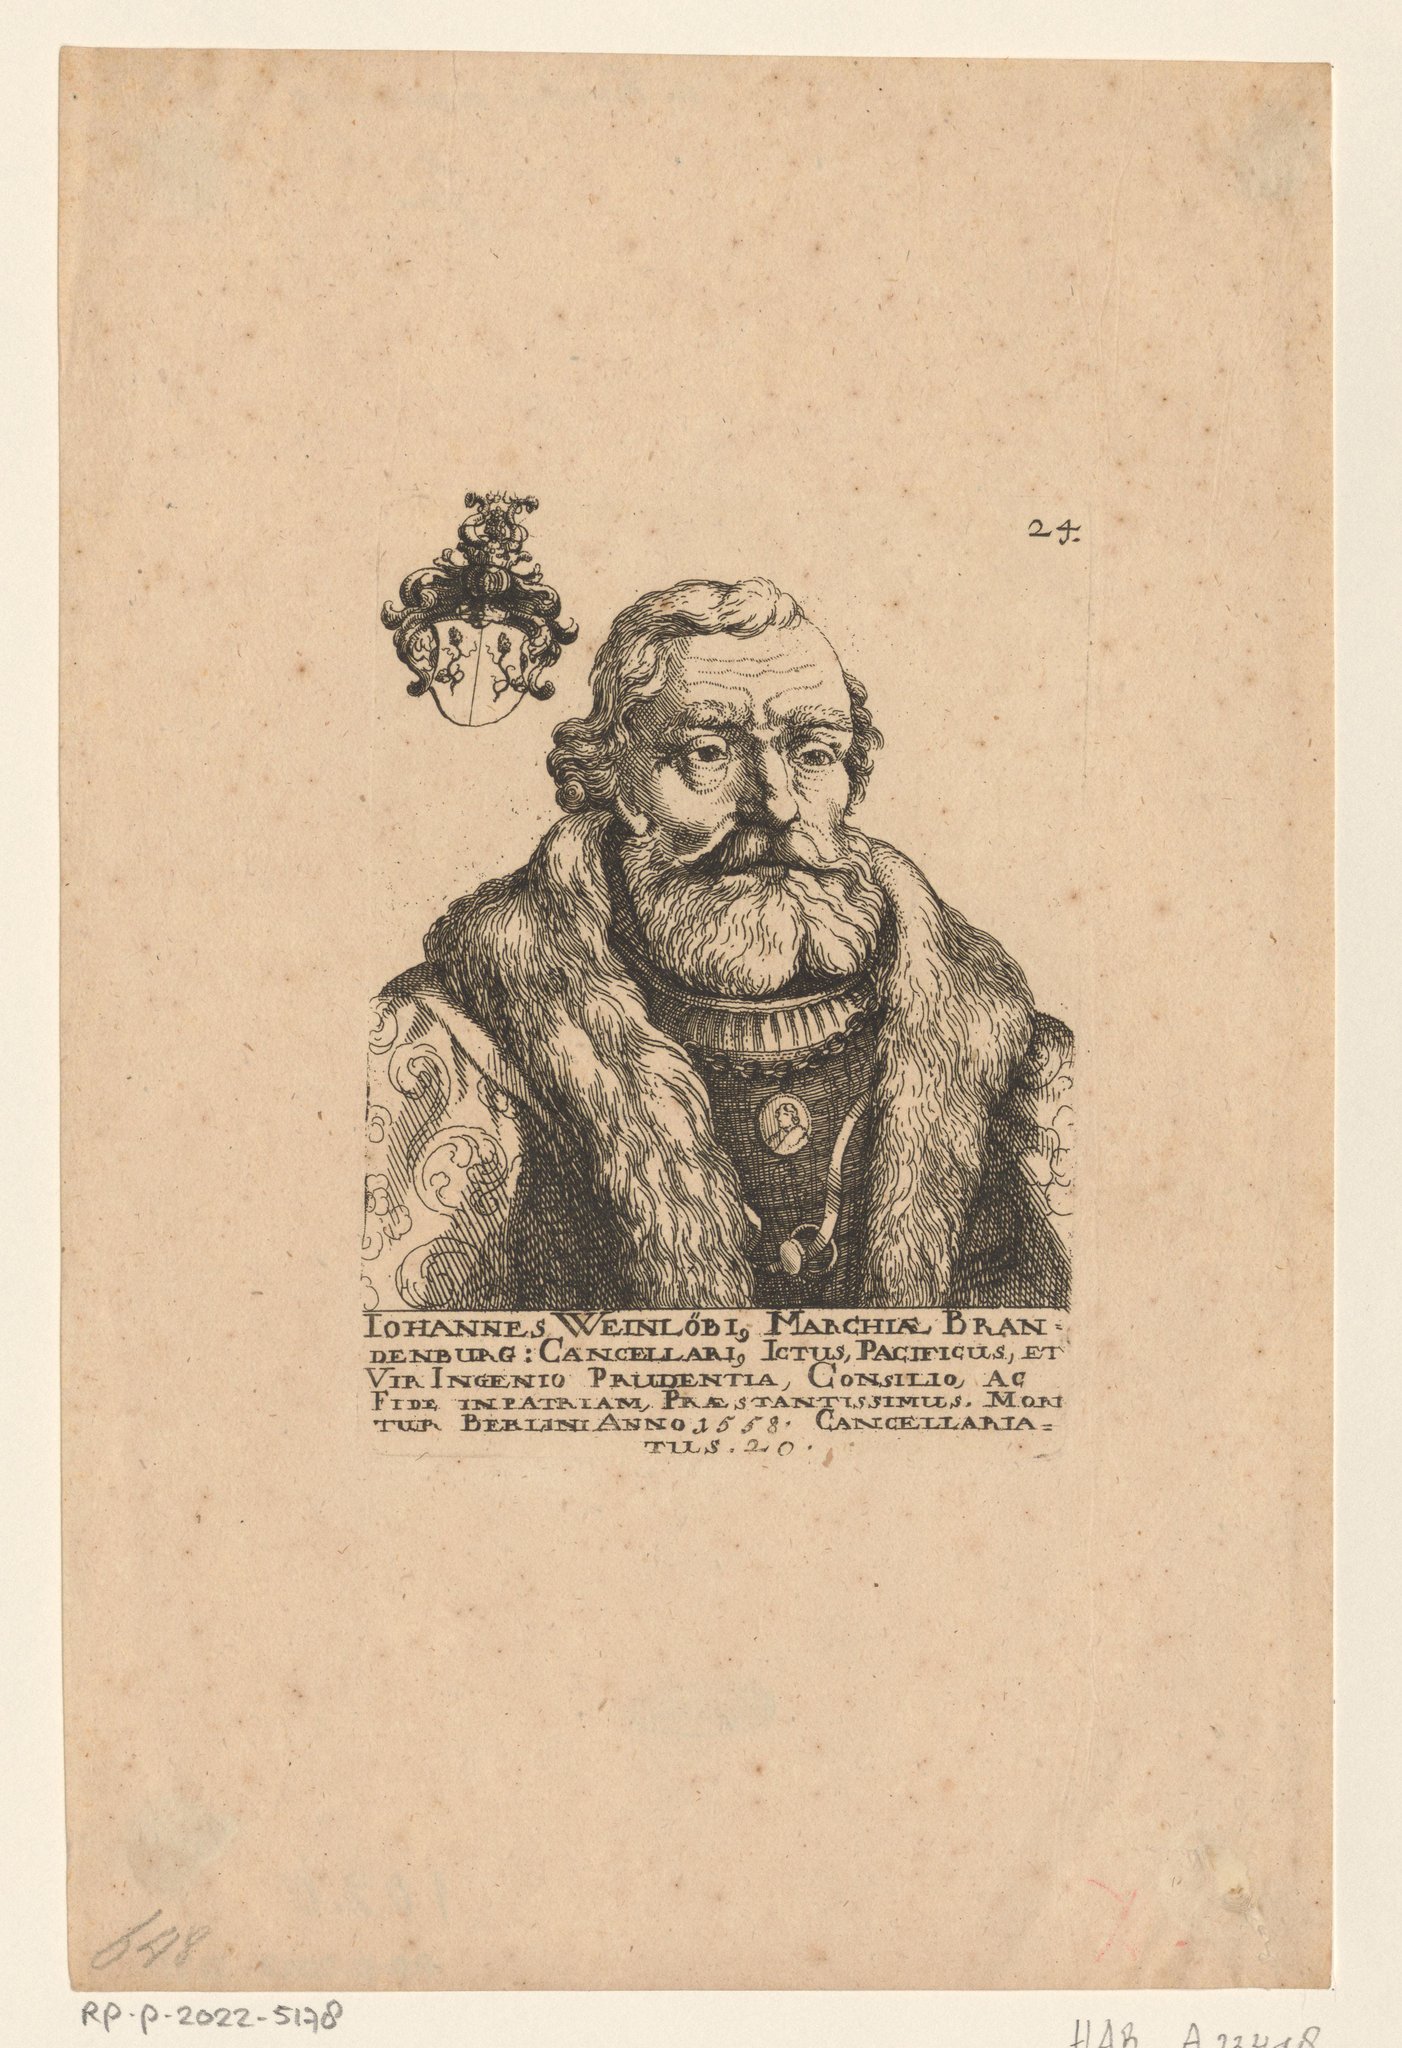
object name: print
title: Portret van Johann Weinlob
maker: Anonymous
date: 1751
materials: paper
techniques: etching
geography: germany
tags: politician, historical persons, pendant, trinket, 'breloque', politician, e.g. party leader, armorial bearing, heraldry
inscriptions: collector's mark: Lugt 2228, number: ‘1020’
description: Latere staat van de prent gebruikt in: Küster, Georg Gottfried. Martin Friedrich Seidels Bilder-Sammlung (...). Berlijn: Buchladen bey der Real Schule, 1751.